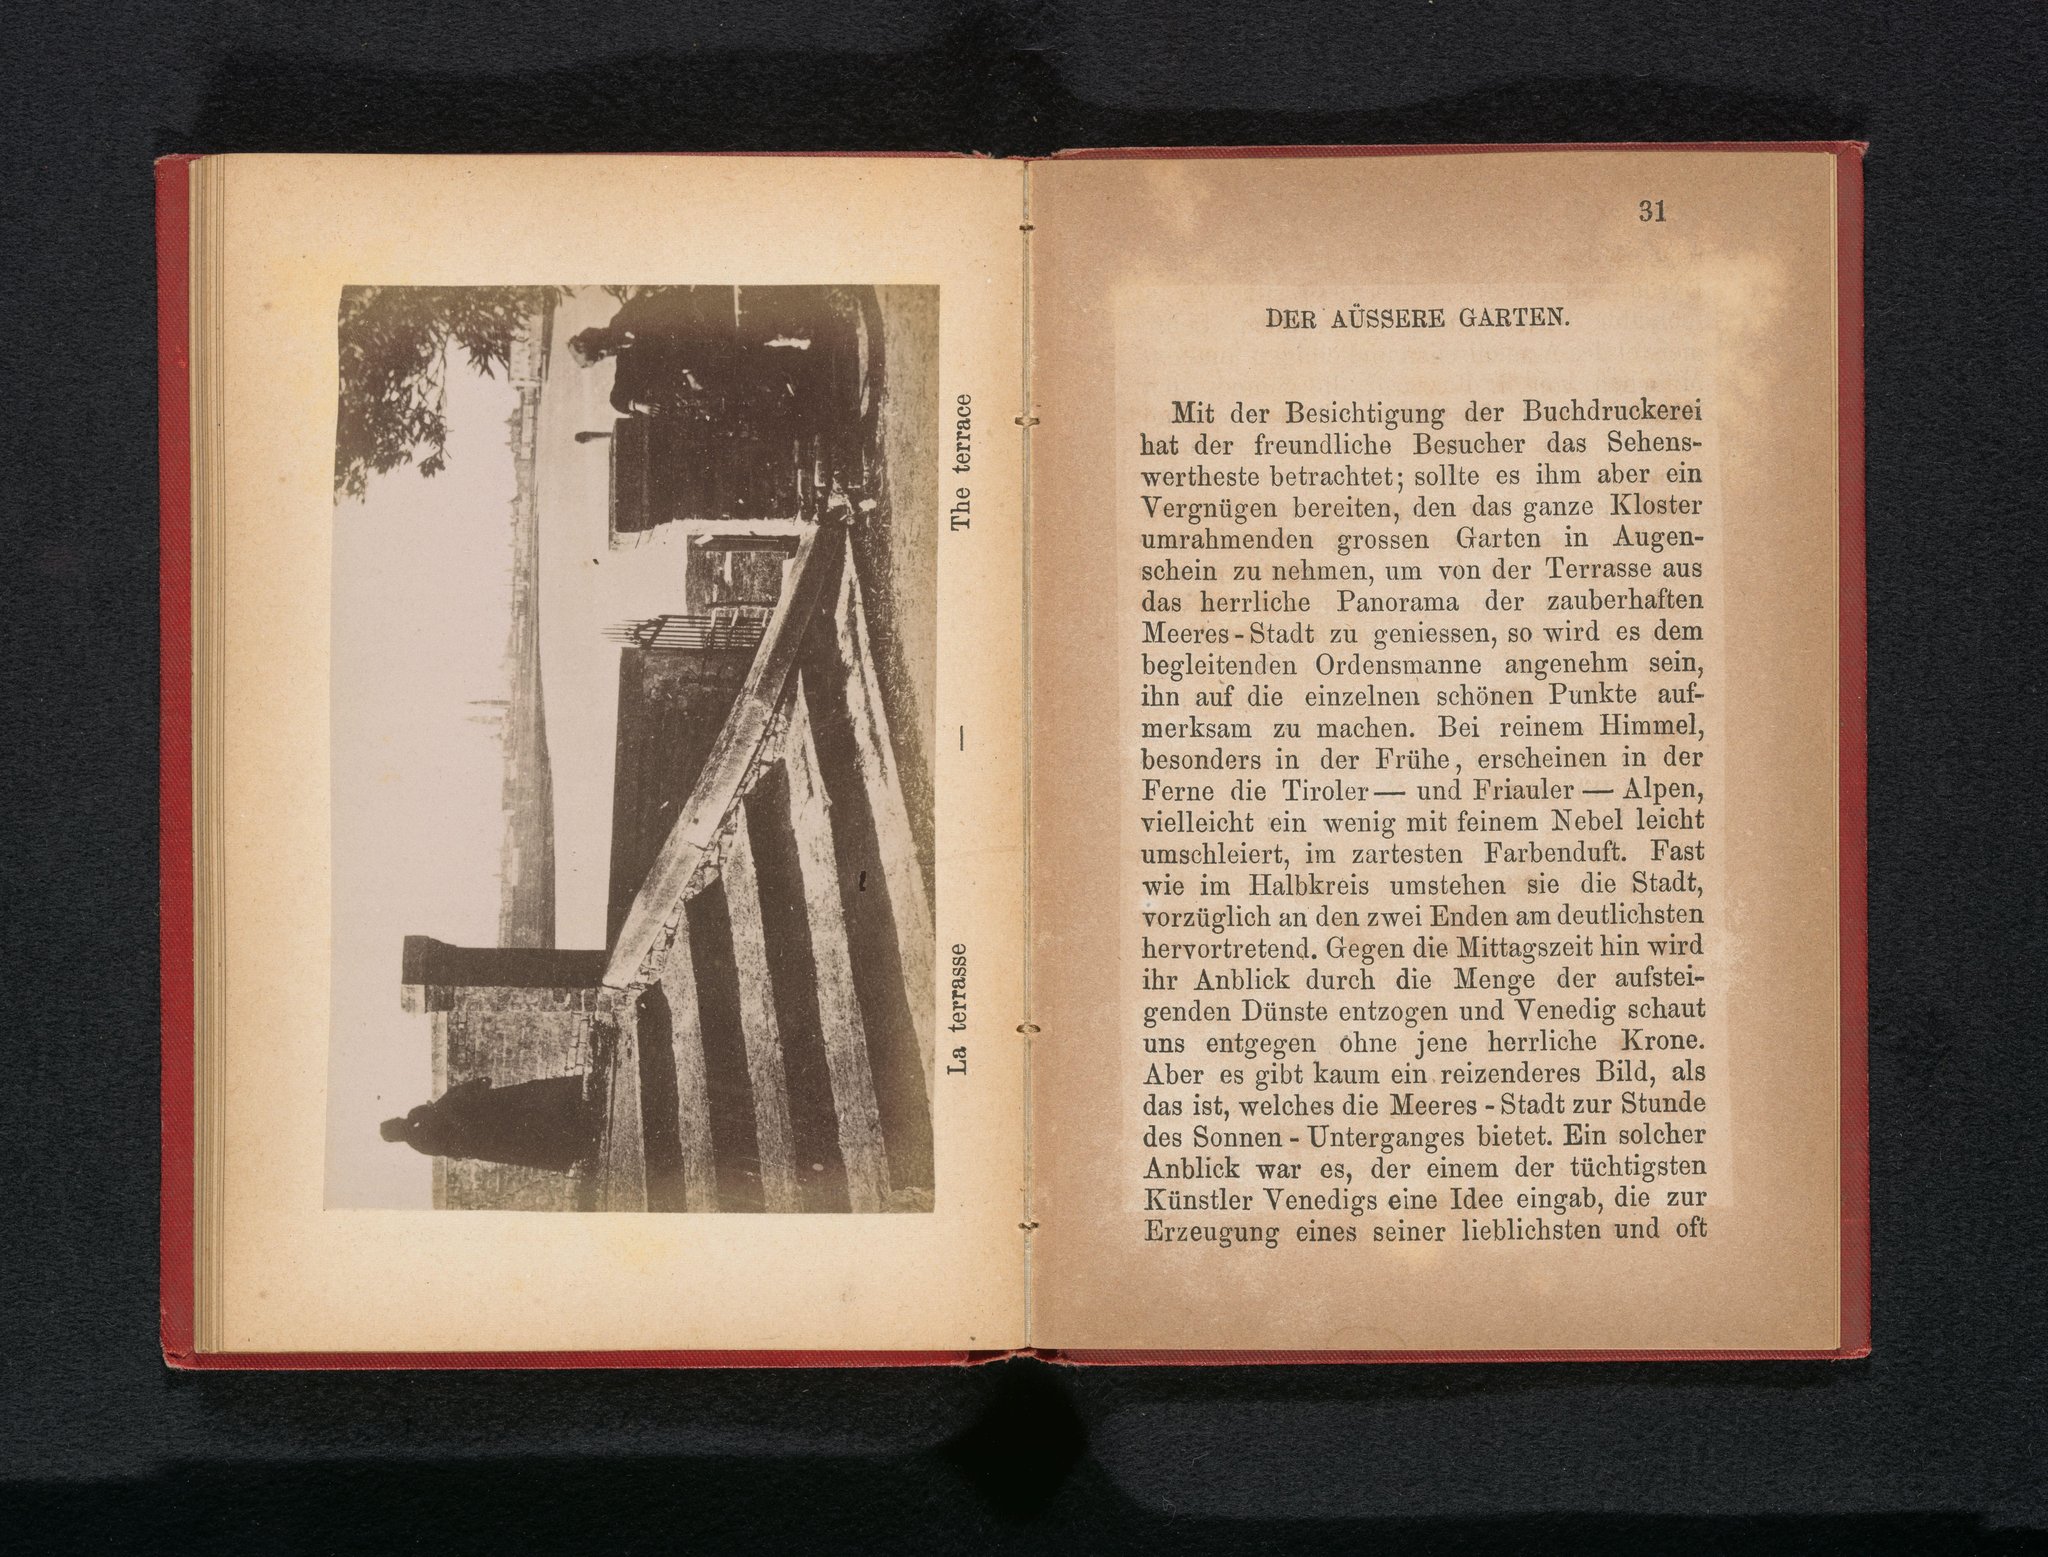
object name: page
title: The terrace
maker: Anonymous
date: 1870-1880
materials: paper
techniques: albumen print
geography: san lazzaro degli armeni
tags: city-view in general; 'veduta', terrace, venice